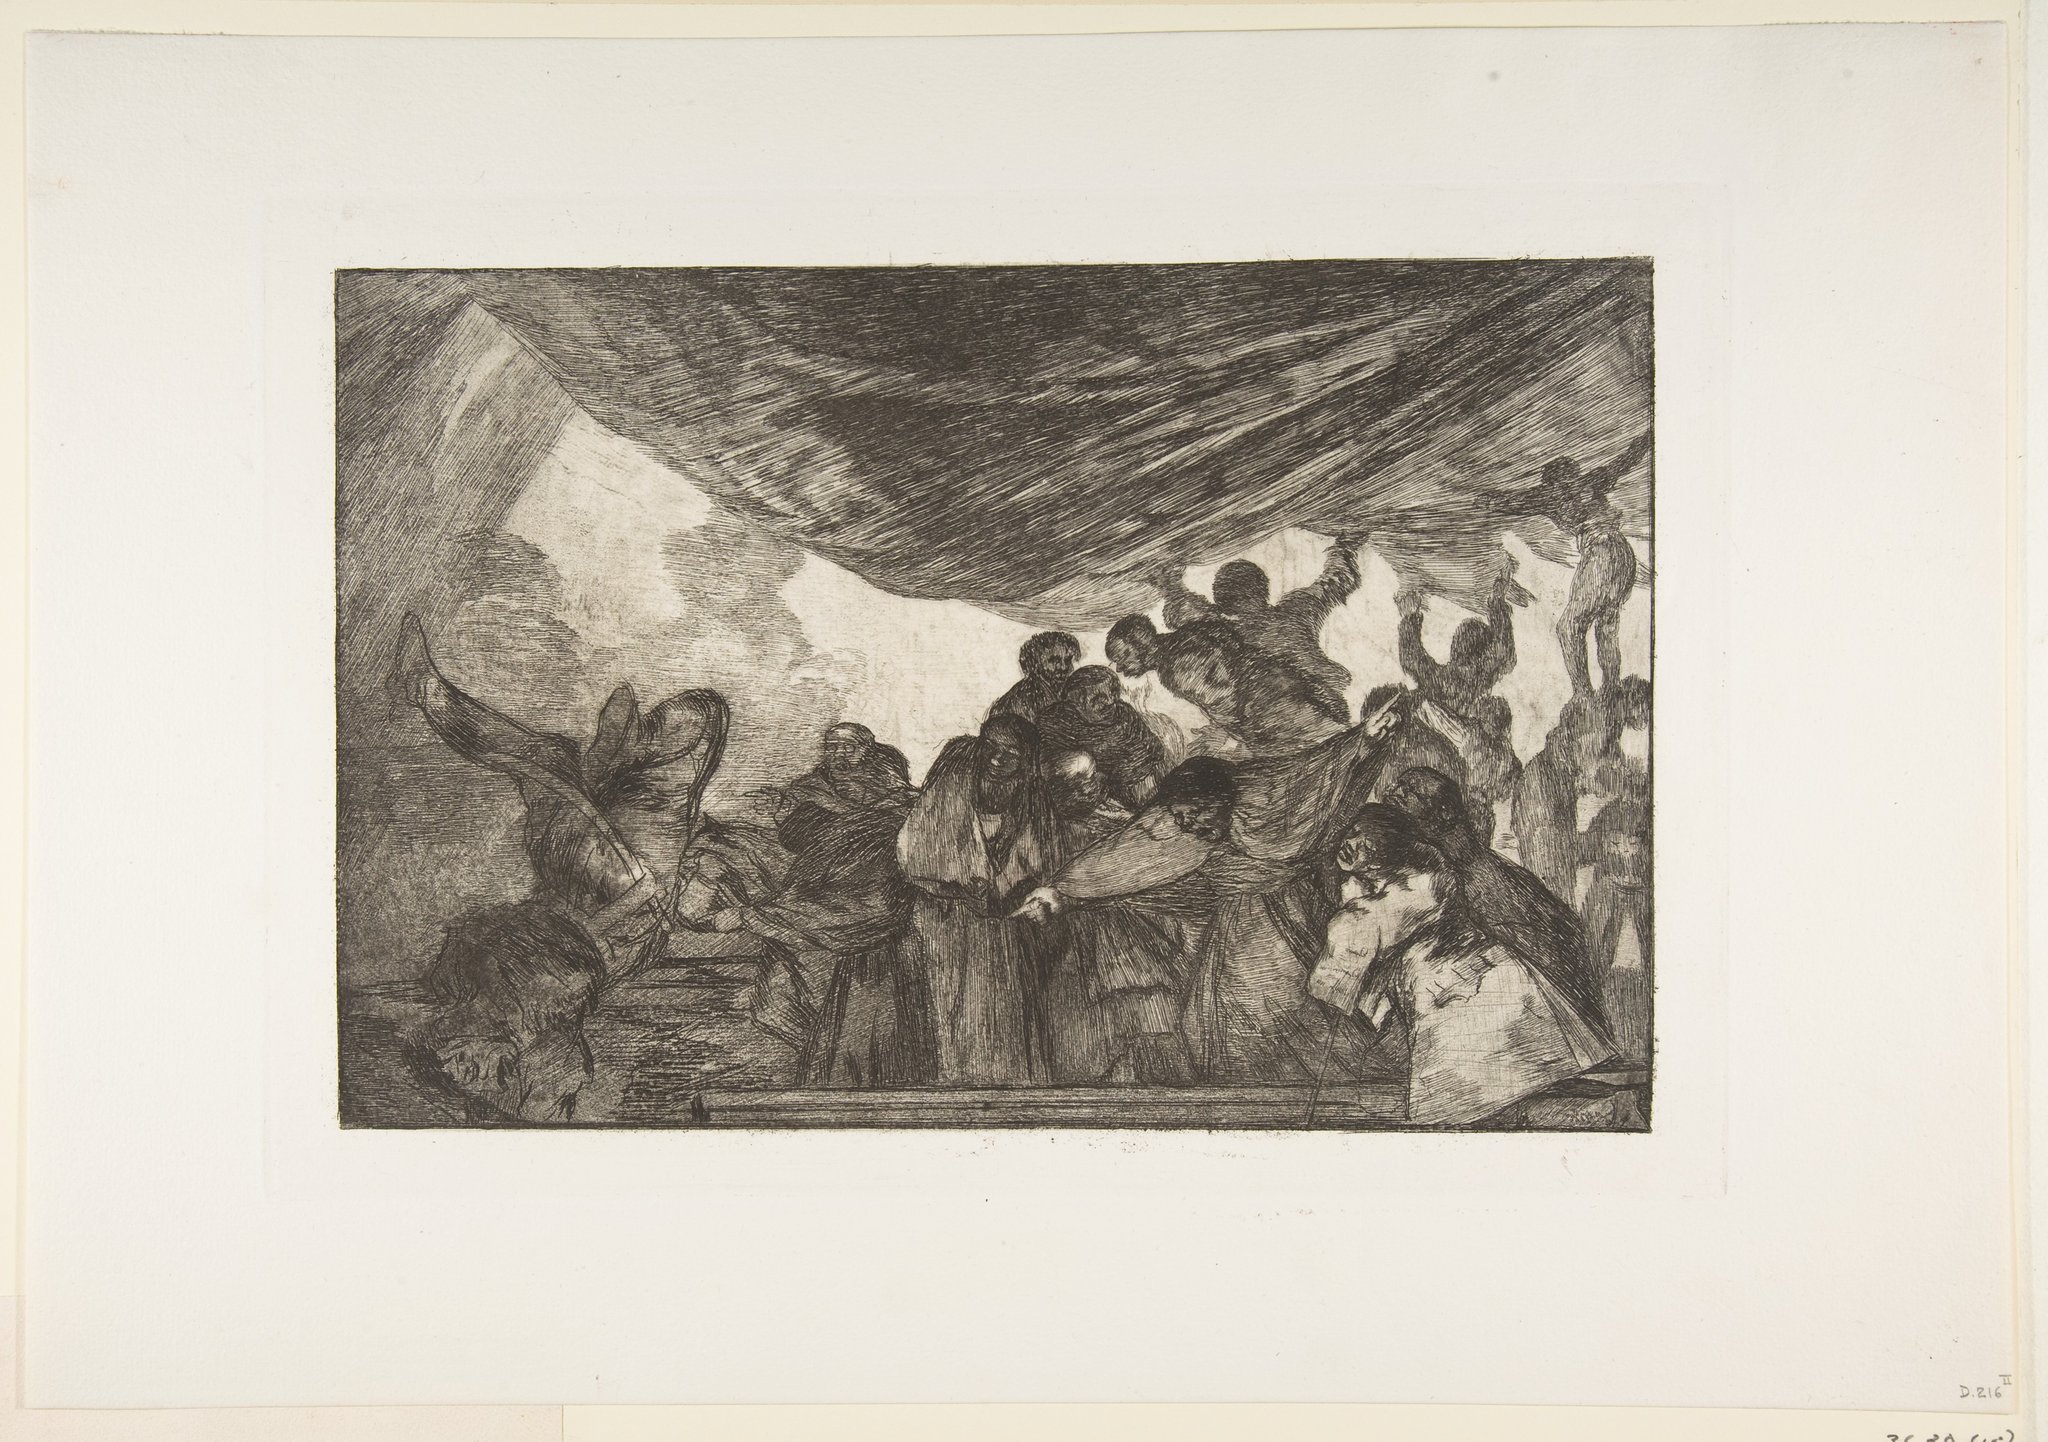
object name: print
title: 'Clear Folly' from the 'Disparates' (Follies / Irrationalities)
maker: goya (francisco de goya y lucientes)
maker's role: artist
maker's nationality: spanish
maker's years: 1746-1828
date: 1815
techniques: aquatint, burnishing, etching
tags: men,women